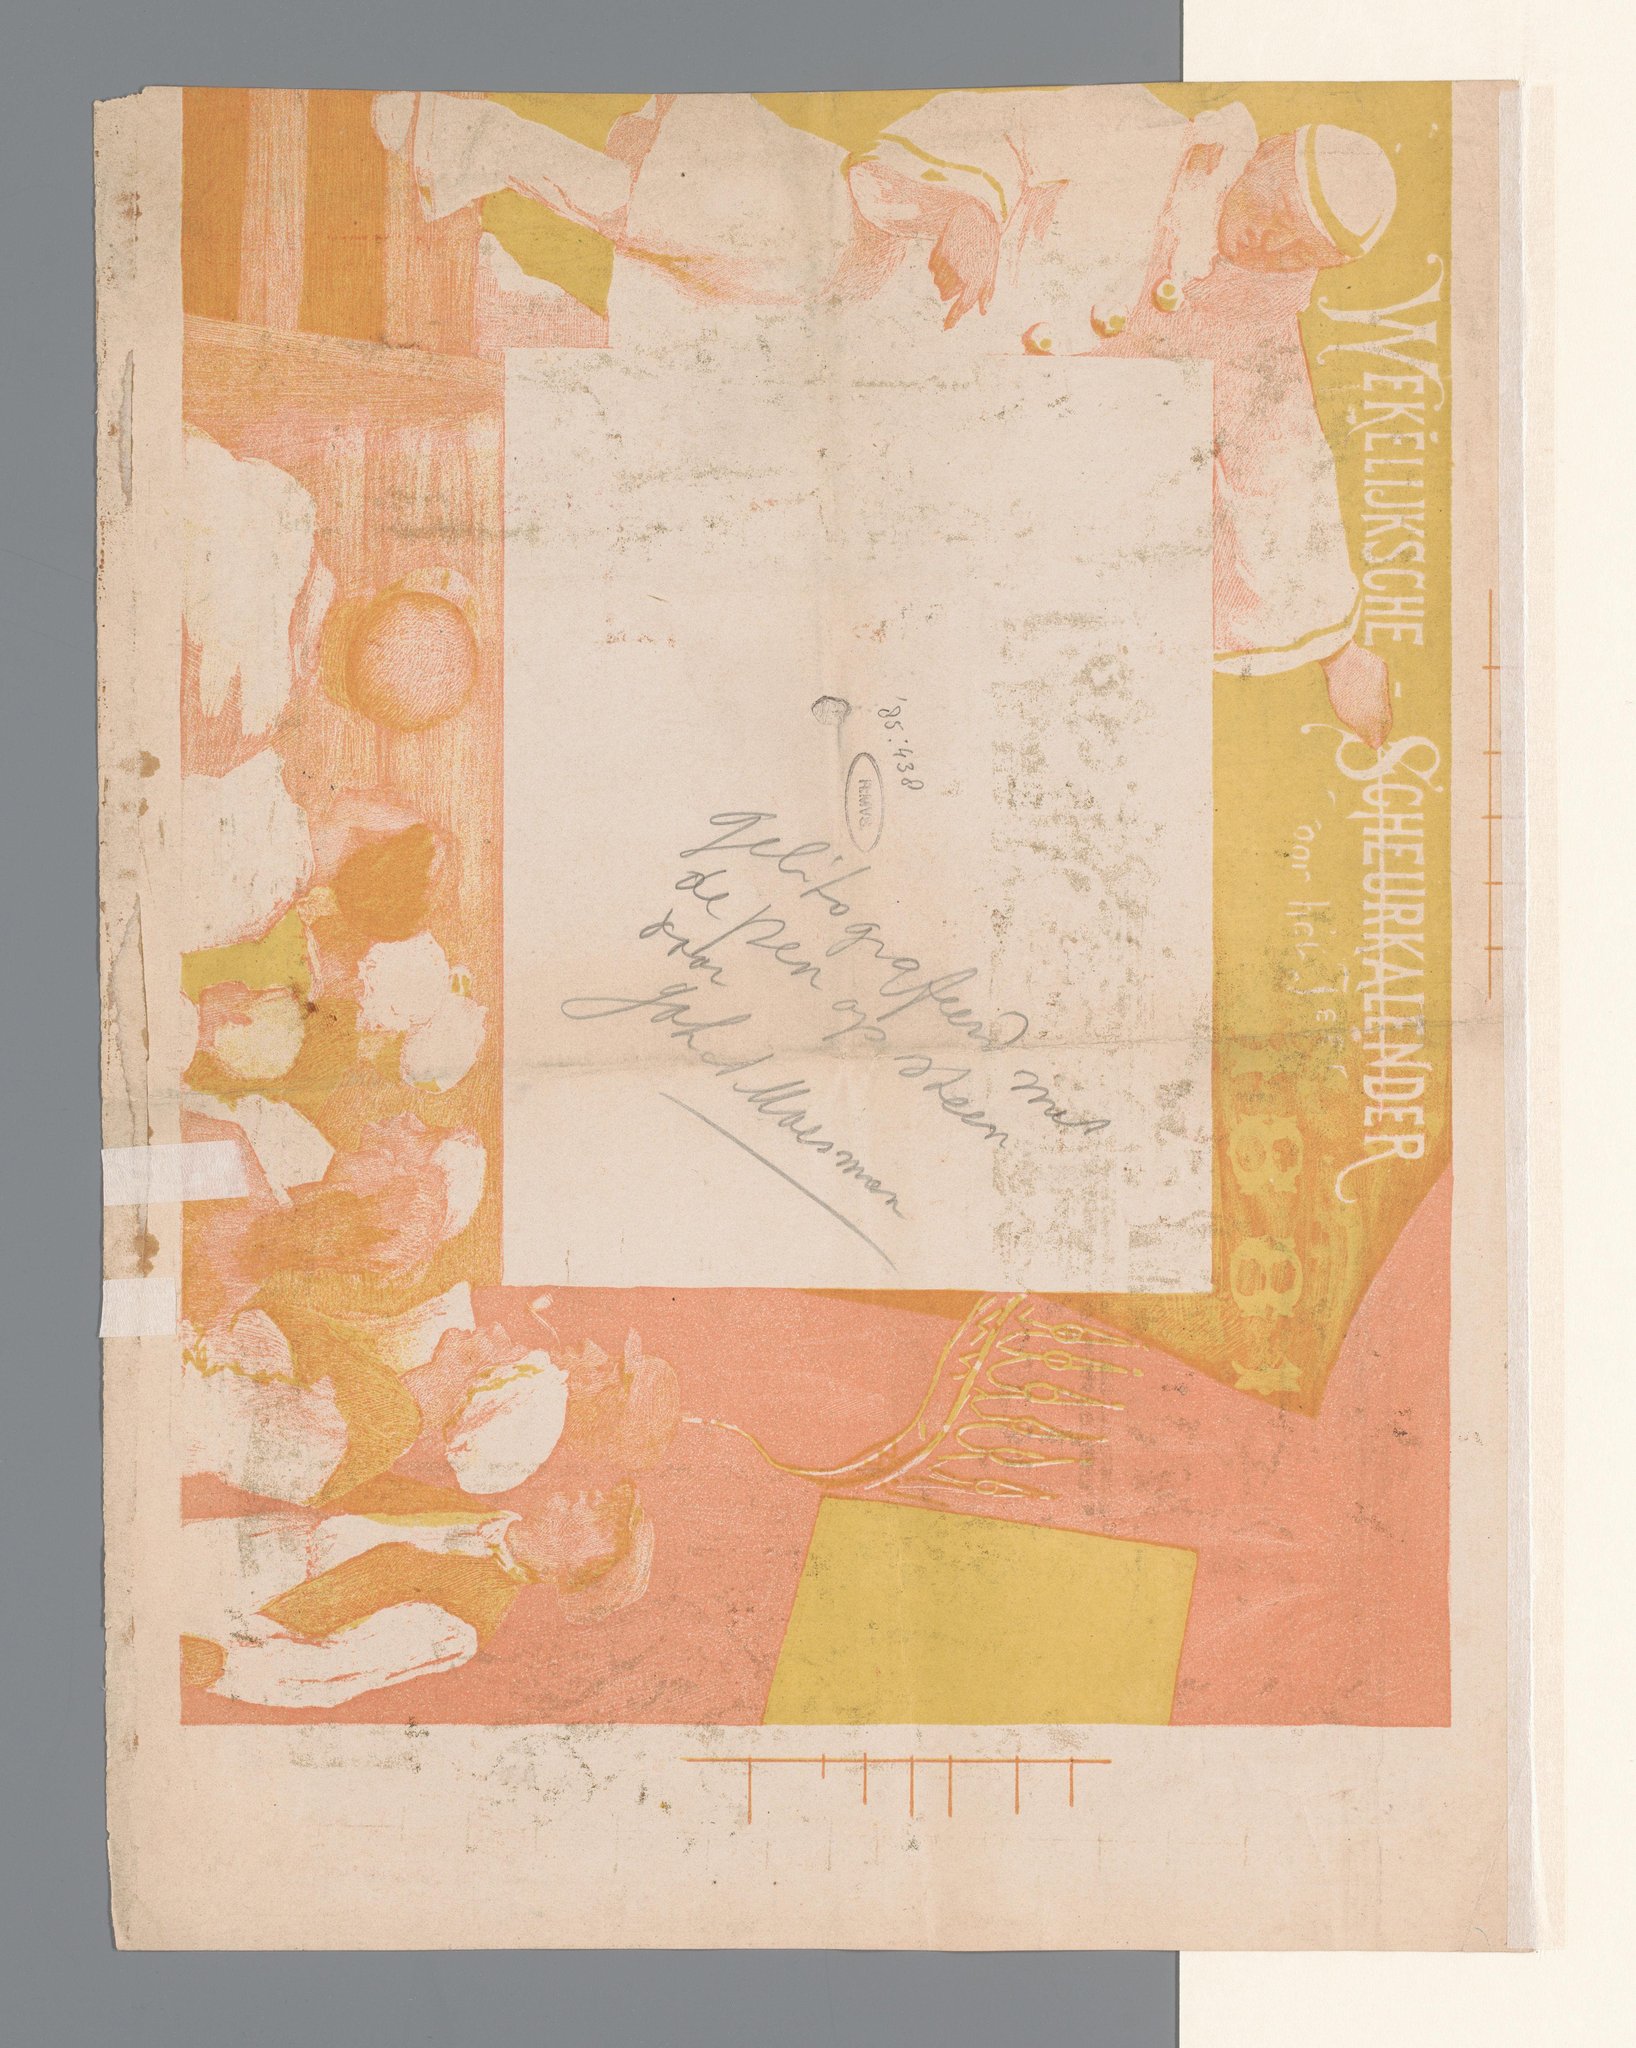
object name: print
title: Wekelijksche scheurkalender 1881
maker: johannes moesman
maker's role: draughtsman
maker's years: 1859-1937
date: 1869-1937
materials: paper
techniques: chromolithography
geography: utrecht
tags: calendar, almanac, the audience ~ art performance, clown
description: De clown heeft zijn hand uitgestrekt. Rechts onder het podium zitten mannen en vrouwen te kijken.